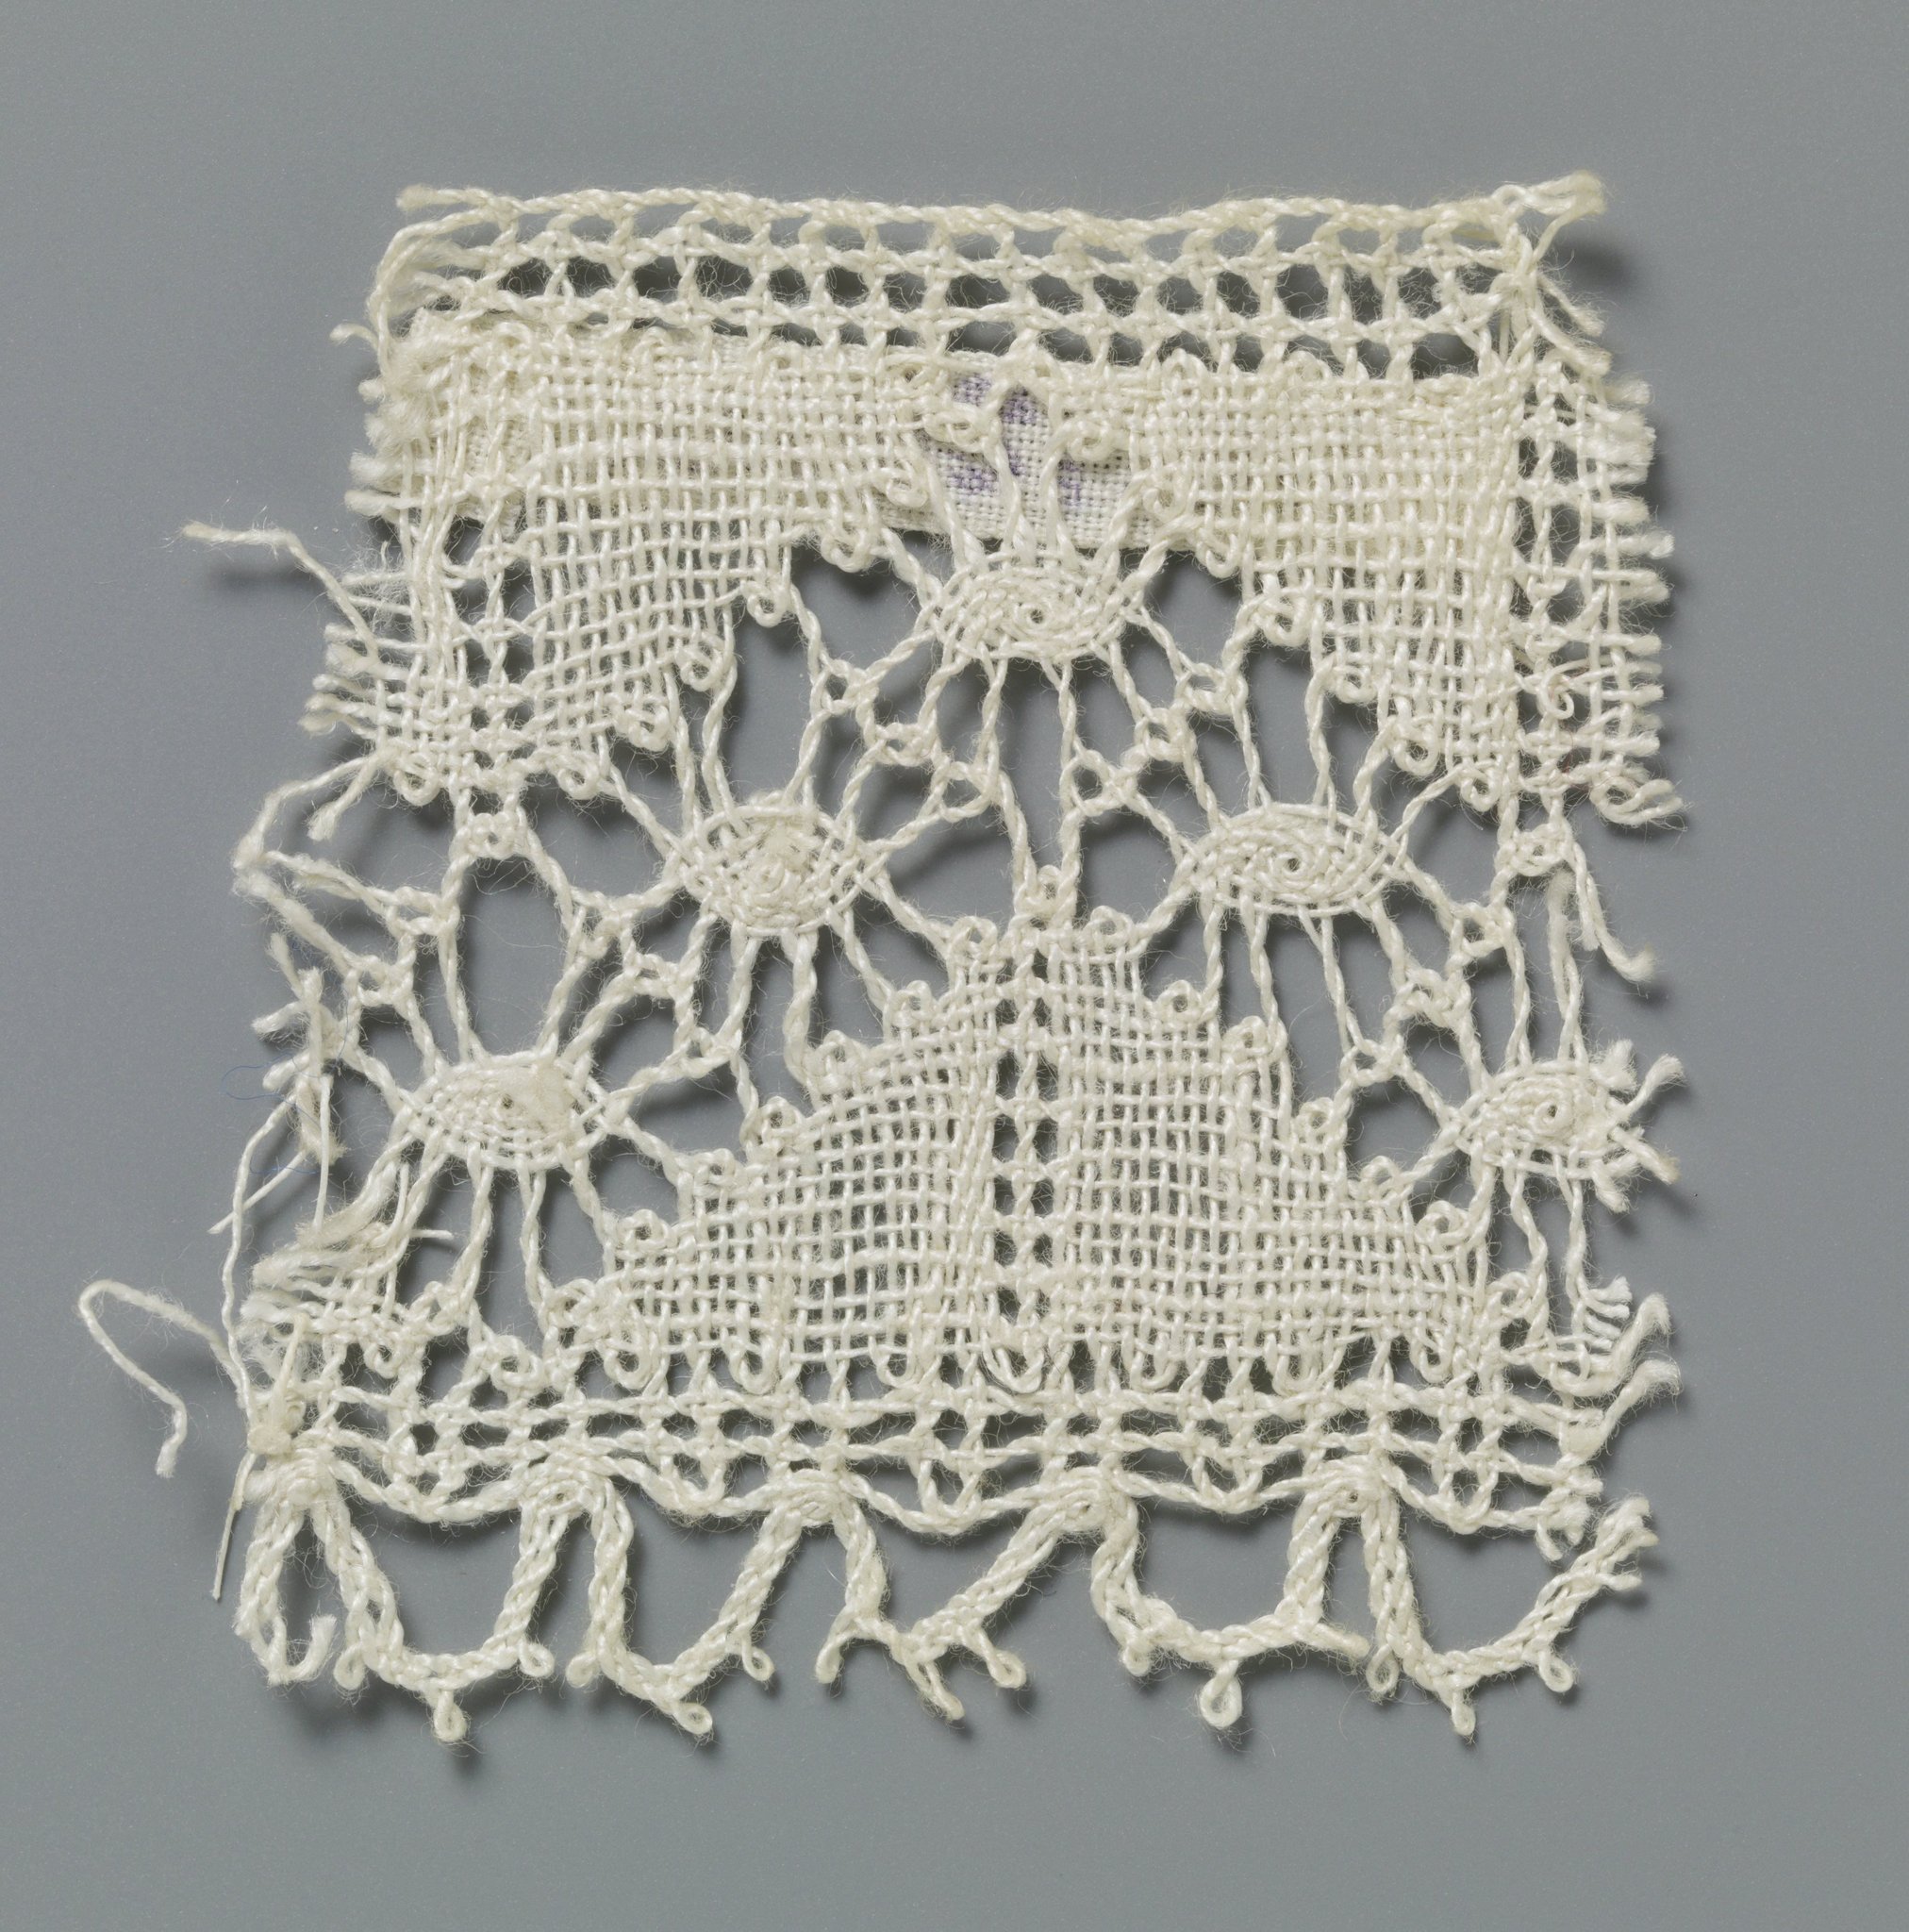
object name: strip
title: Strook kloskant met spitsovaaltjes in omgekeerde v-vormige band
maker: Anonymous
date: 1800-1899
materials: cotton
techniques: lace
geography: buckingham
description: Strook naturelkleurige kloskant, stropkant. Het patroon bestaat uit een opengewerkte en omgekeerde v-vormige band, waarin spitsovaaltjes tussen overstekende paren zijn gemaakt. De driehoekige velden die langs de boven- en onderkant van de zigzag-band ontstaan, zijn gemaakt in linnenslag. De bovenzijde van de strook is recht afgewerkt. De onderzijde is afgewerkt met boogjes, gemaakt met een doorlopend vlechtje dat per boogje is voorzien van drie picots.